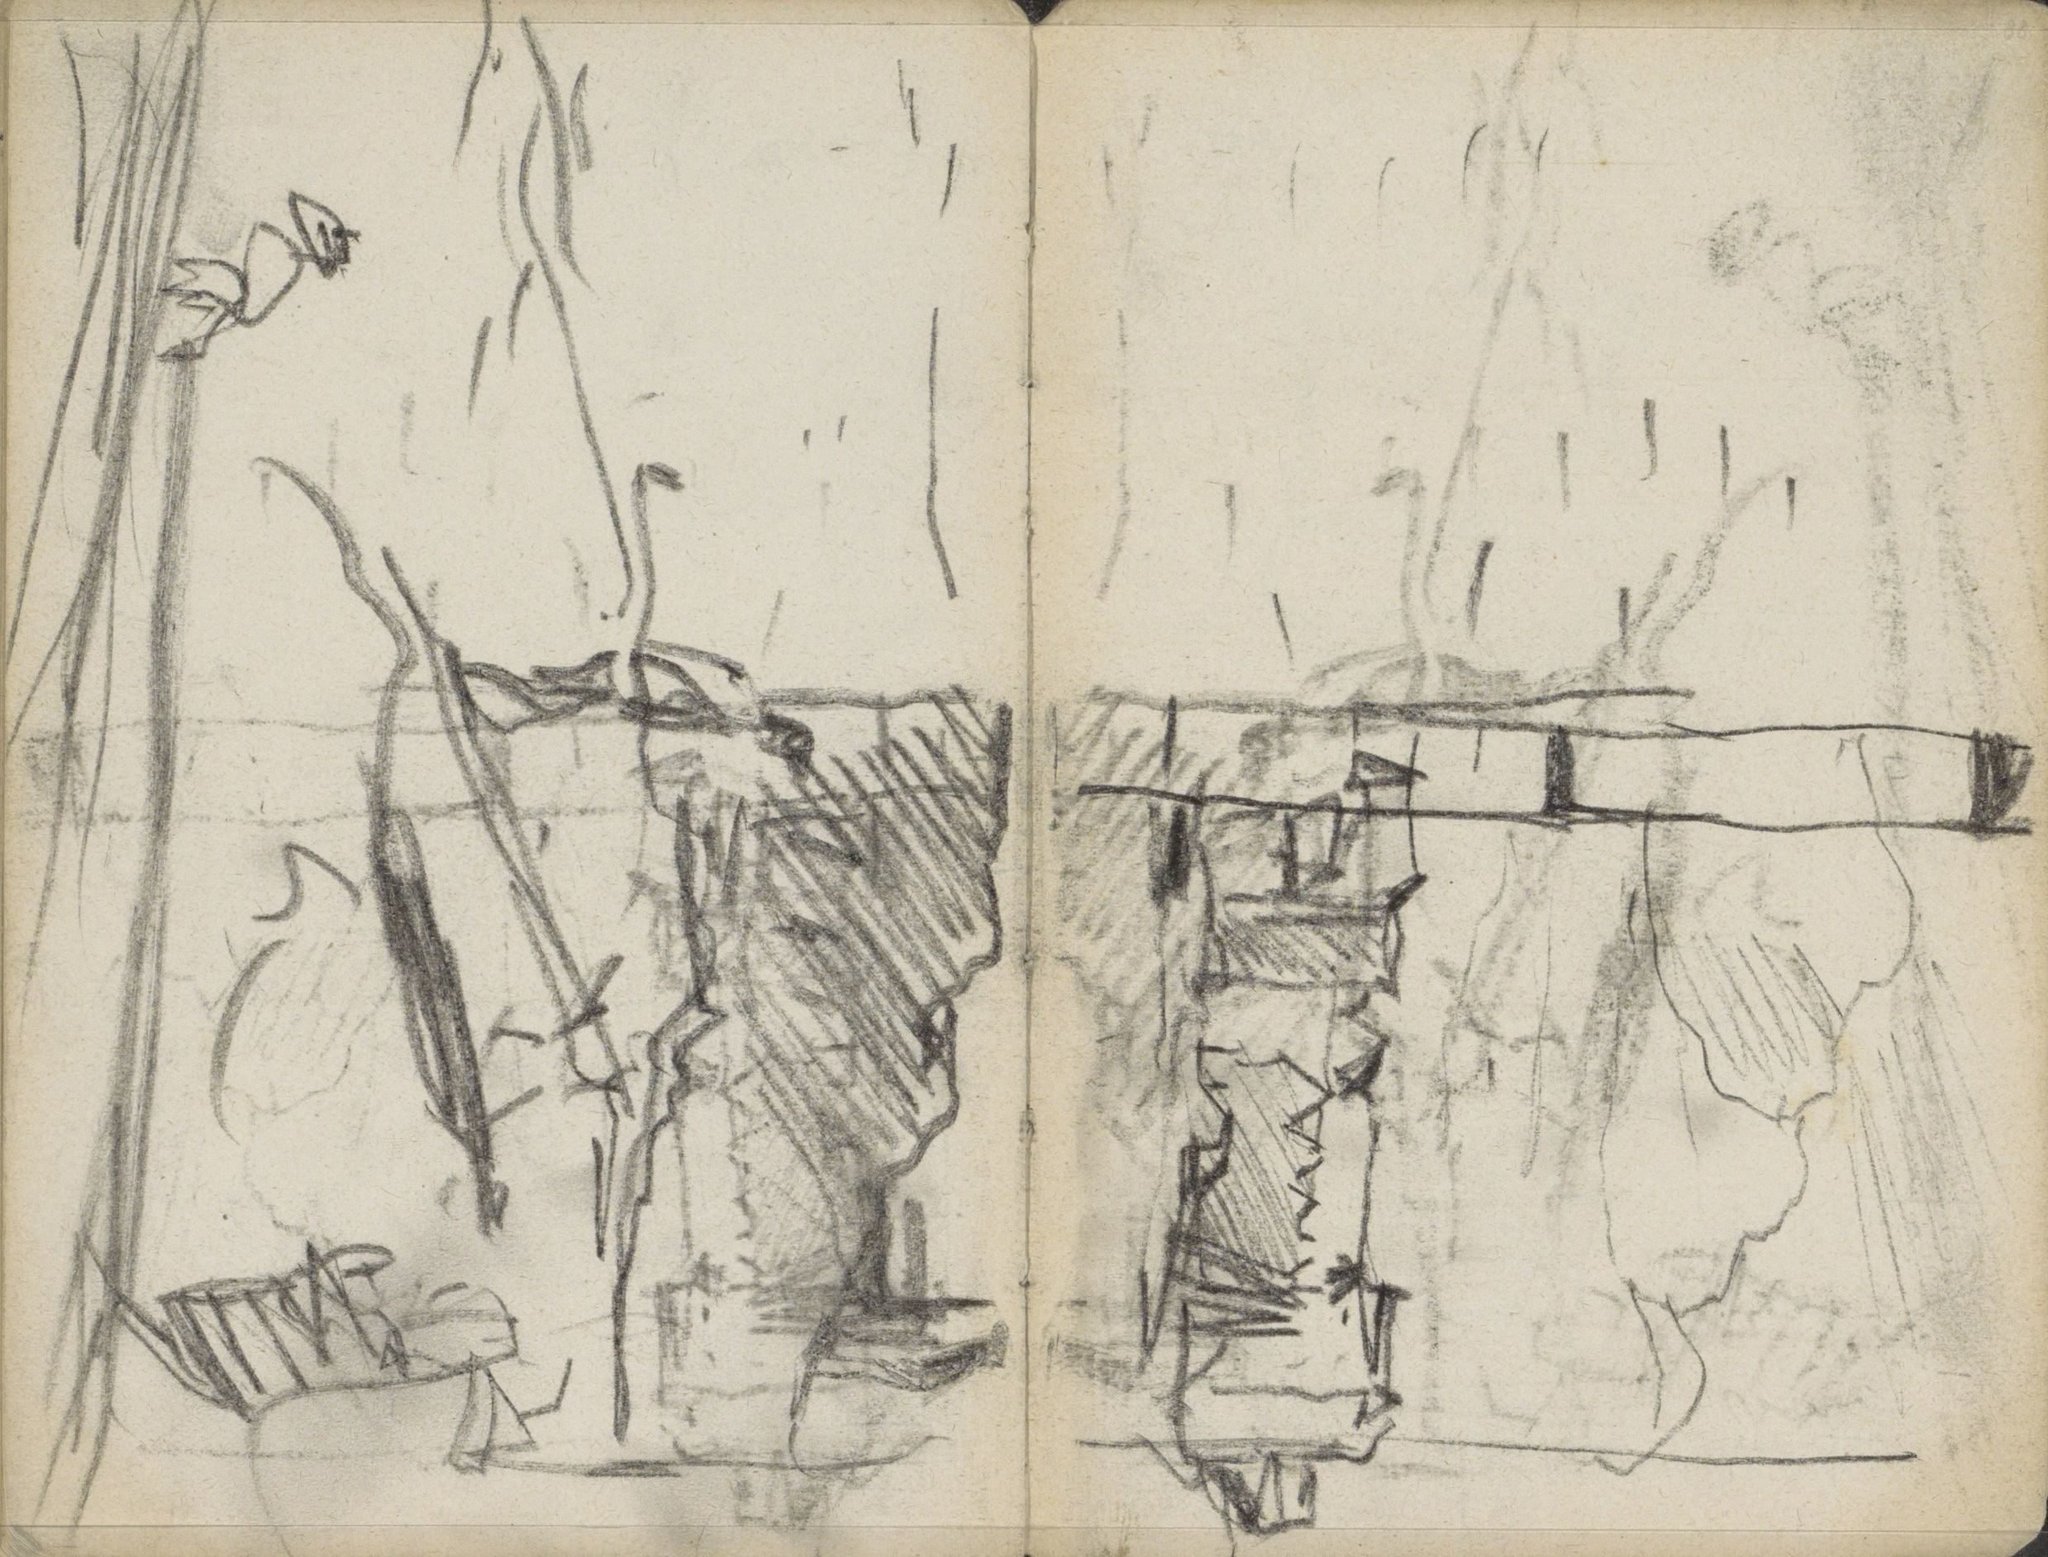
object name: sketchbook leaf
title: Gezicht in Amsterdam, mogelijk in de Van Lennepbuurt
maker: george hendrik breitner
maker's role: draughtsman, painter, print maker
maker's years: 1857-1923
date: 1900-1901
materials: chalk, paper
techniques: stumping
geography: amsterdam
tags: urban housing, street (+ city(-scape) with figures, staffage)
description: Gezicht in Amsterdam, mogelijk in de Van Lennepbuurt. Links een muur. Vooraan een figuur. Pagina 87 en pagina 88 uit een schetsboek met 46 bladen vervaardigd te Amsterdam.